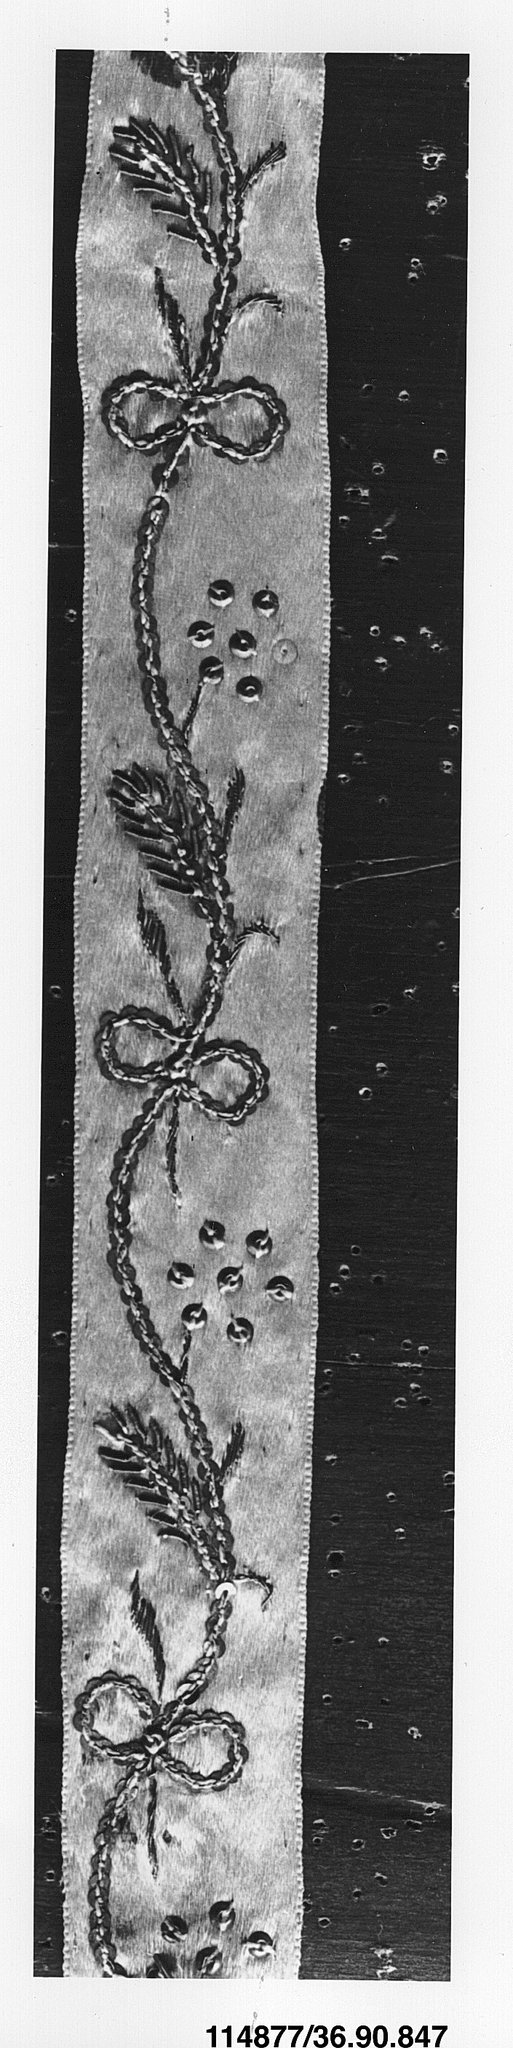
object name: piece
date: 1767-1800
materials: metal thread, silk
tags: leaves